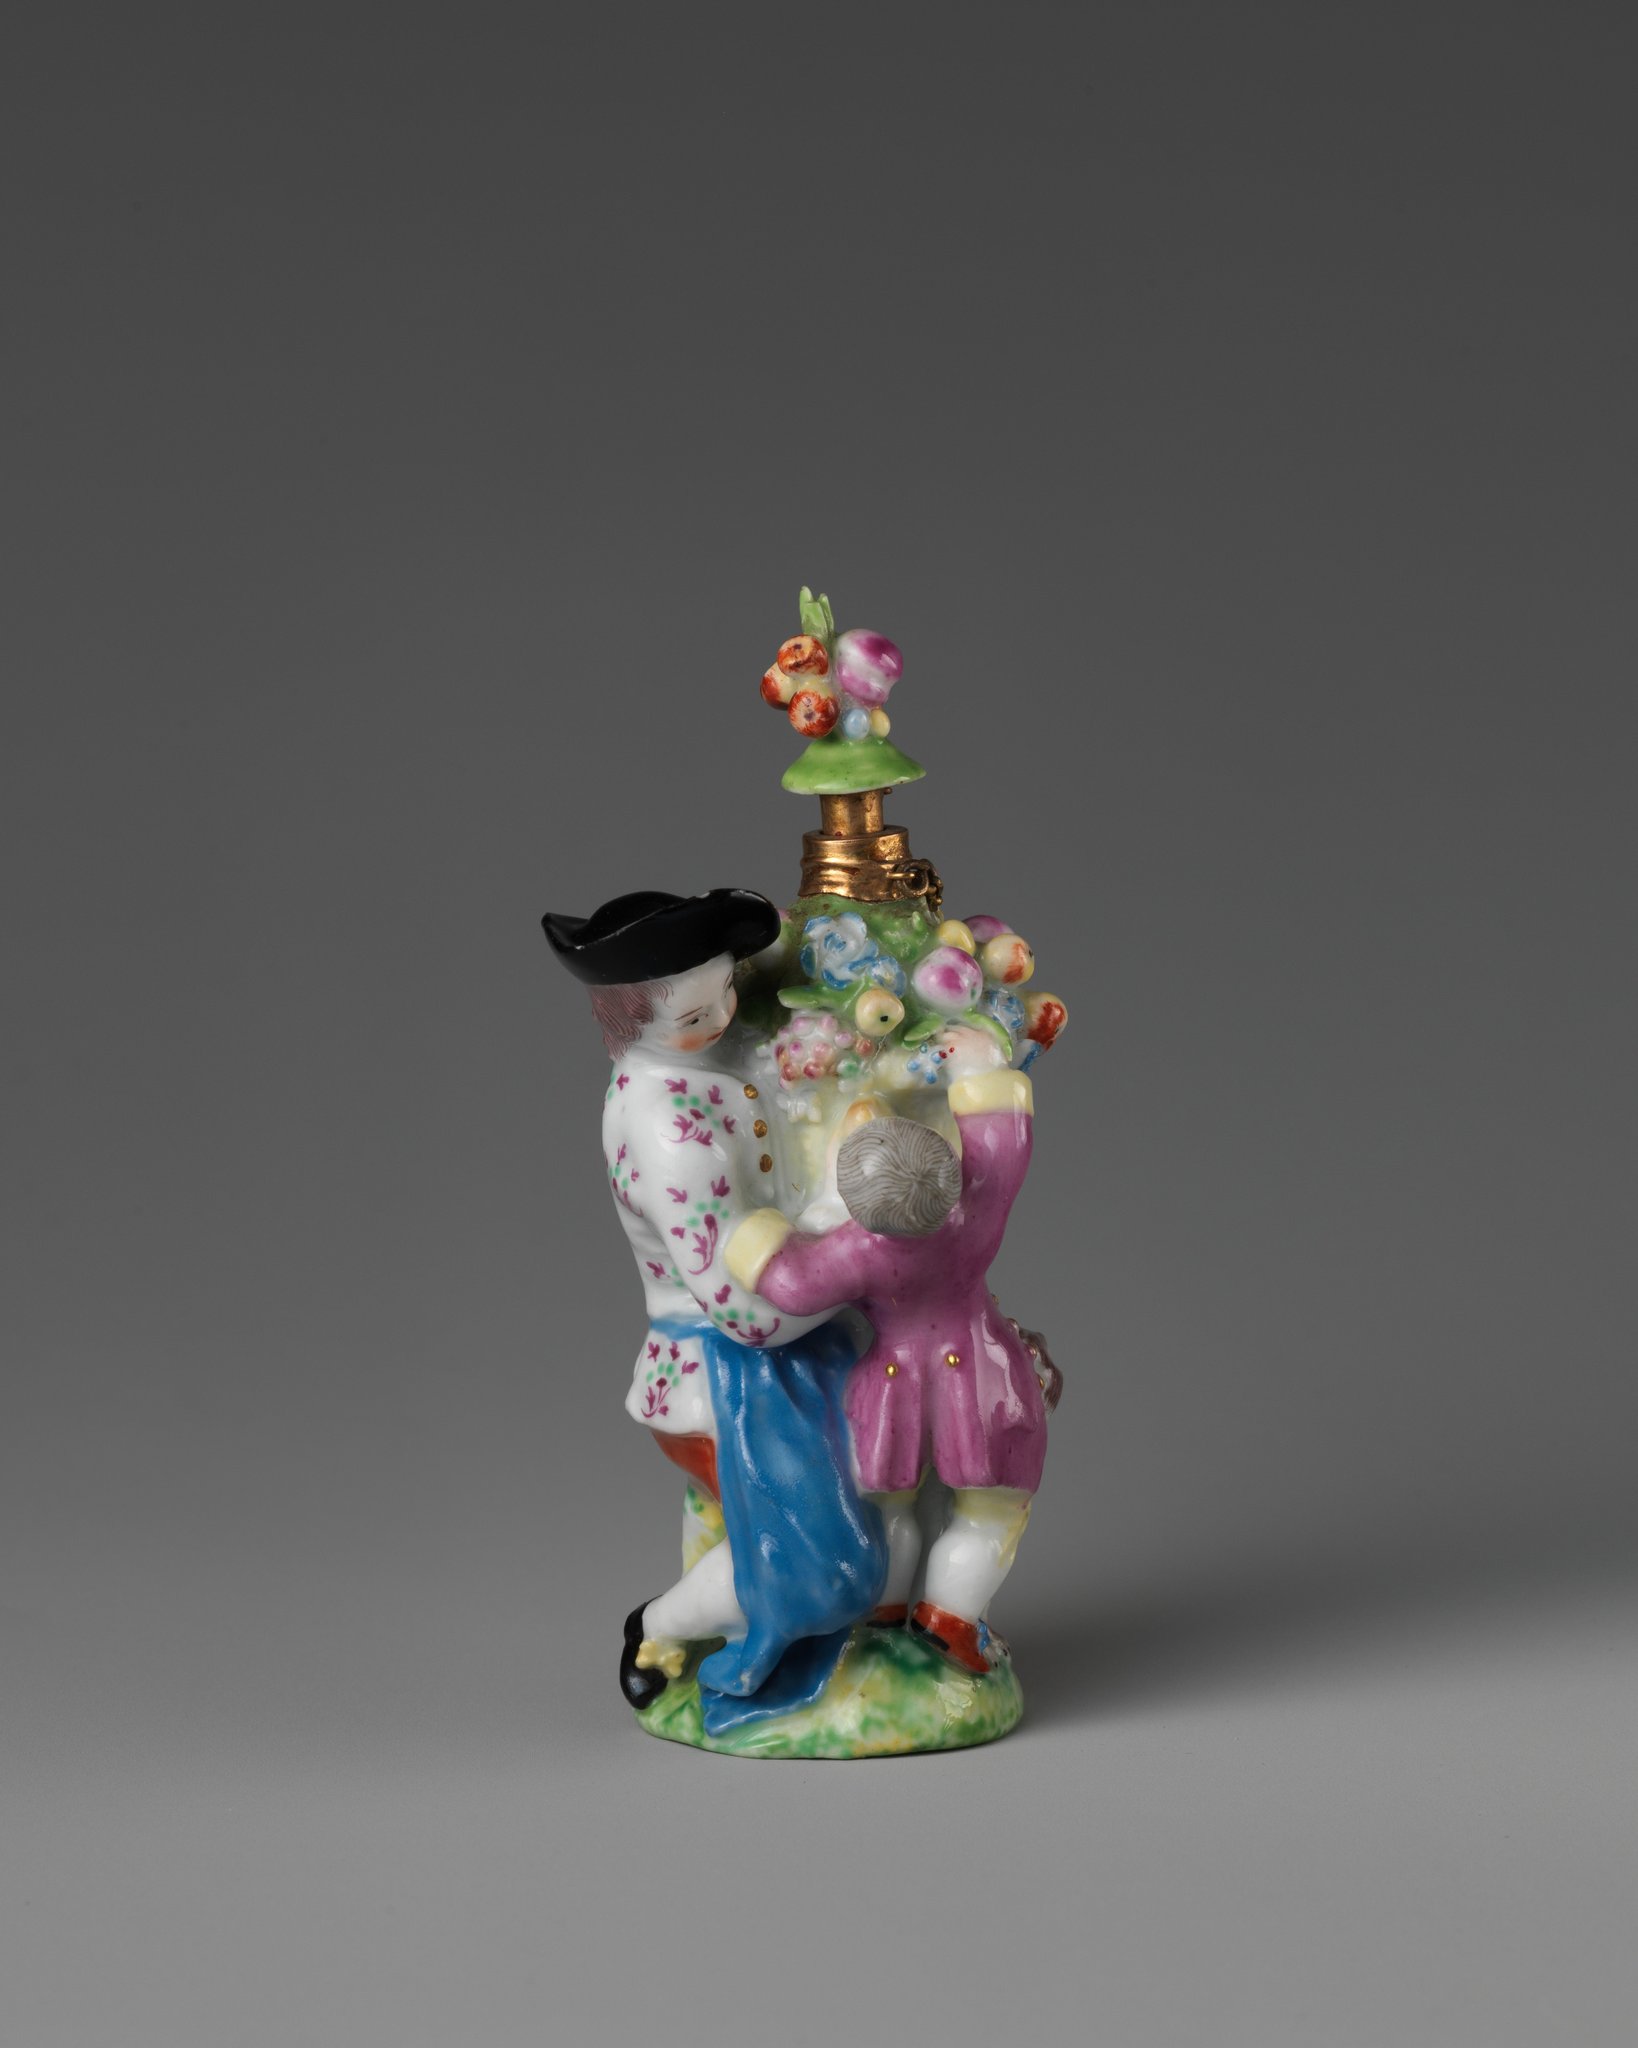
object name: toy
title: Gardener and boy in a group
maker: chelsea porcelain manufactory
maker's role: factory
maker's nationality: british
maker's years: 1744-1784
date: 1765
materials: soft paste porcelain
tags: boys,flowers,gardeners